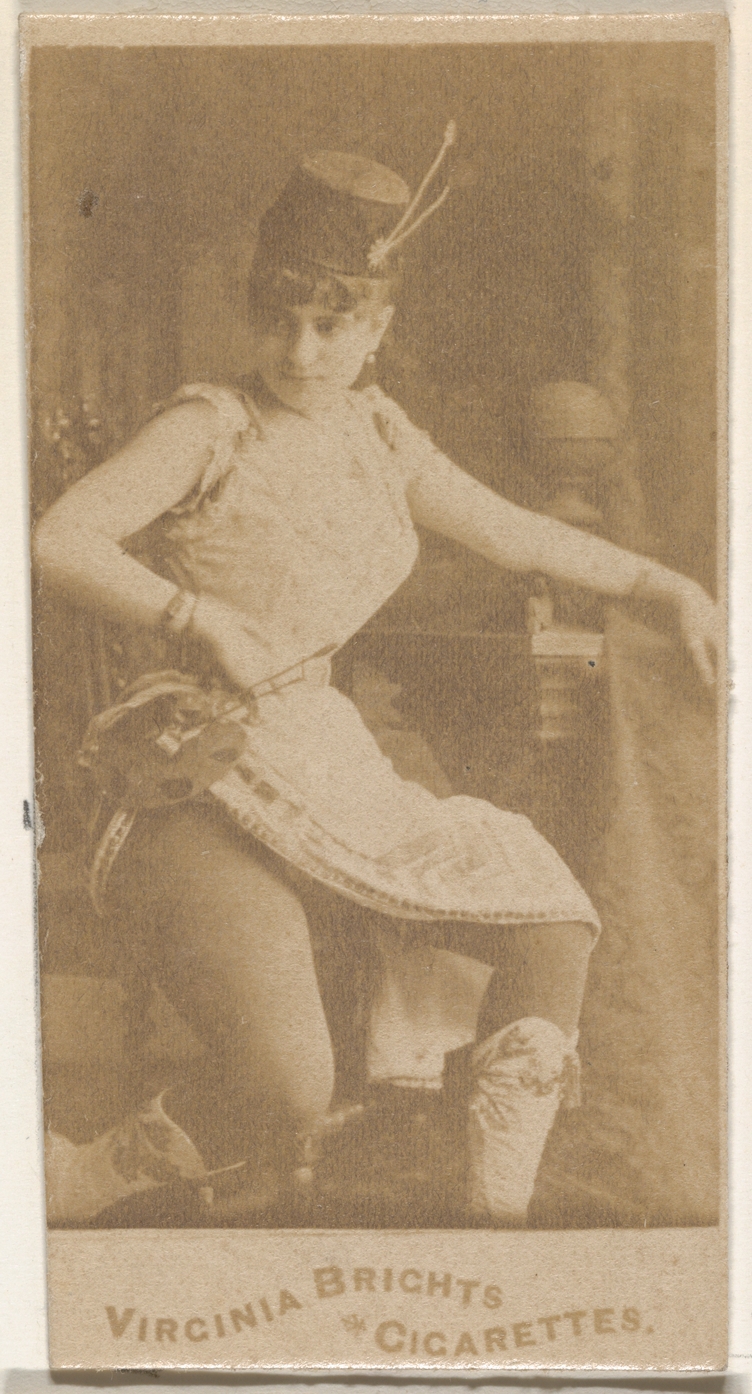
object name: photograph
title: From the Actors and Actresses series (N45, Type 5) for Virginia Brights Cigarettes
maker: allen & ginter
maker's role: publisher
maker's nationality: american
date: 1888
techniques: albumen silver print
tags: portraits,women,actresses